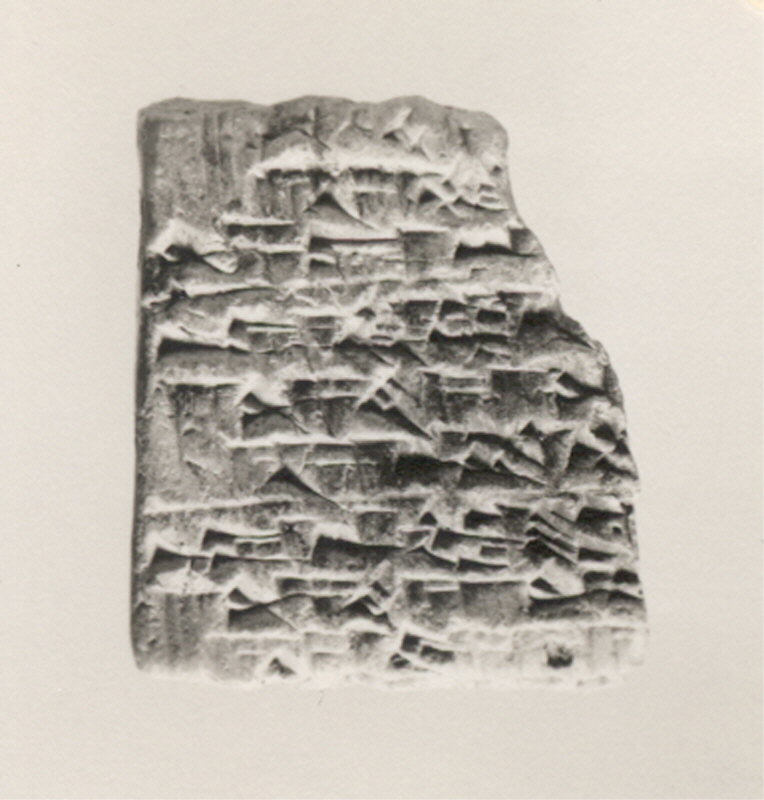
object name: cuneiform tablet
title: Cuneiform tablet: temple account of bread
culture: achaemenid or babylonian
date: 700-301 BCE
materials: clay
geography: mesopotamia